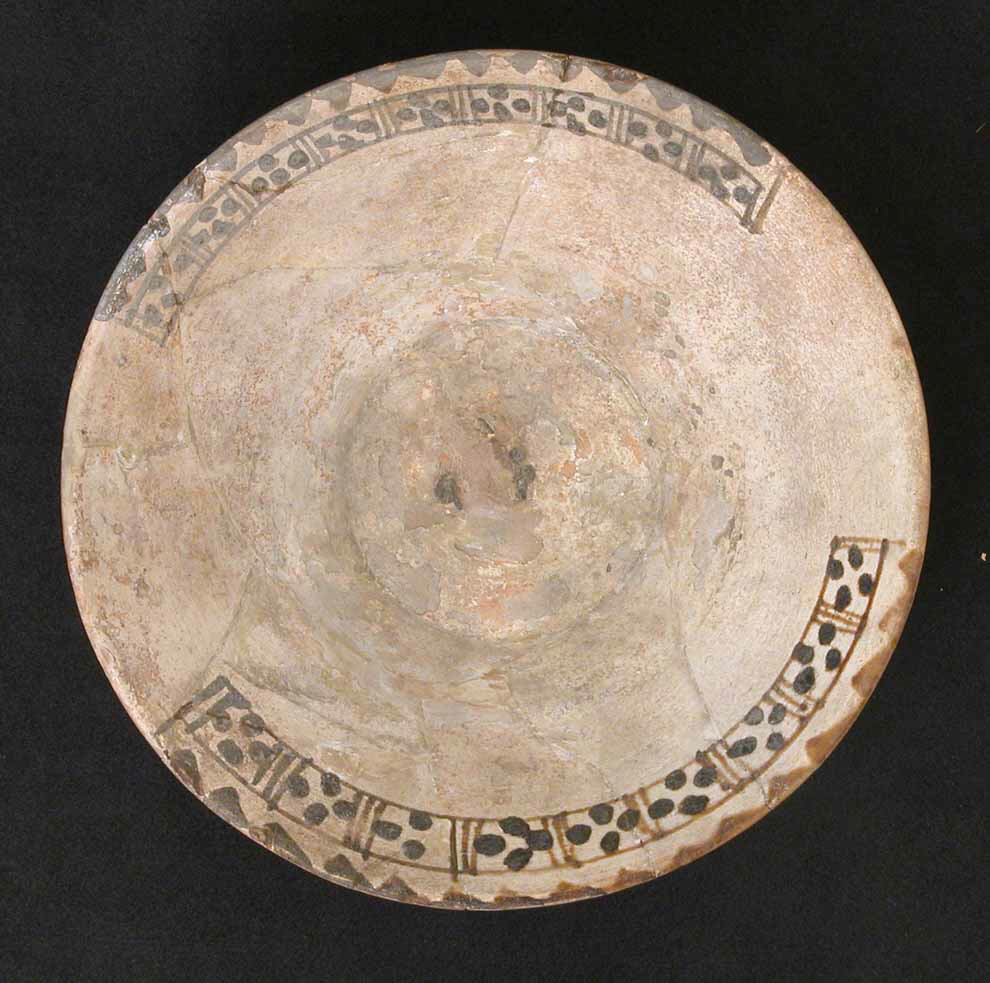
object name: bowl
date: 901-1000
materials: earthenware, glaze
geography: iran